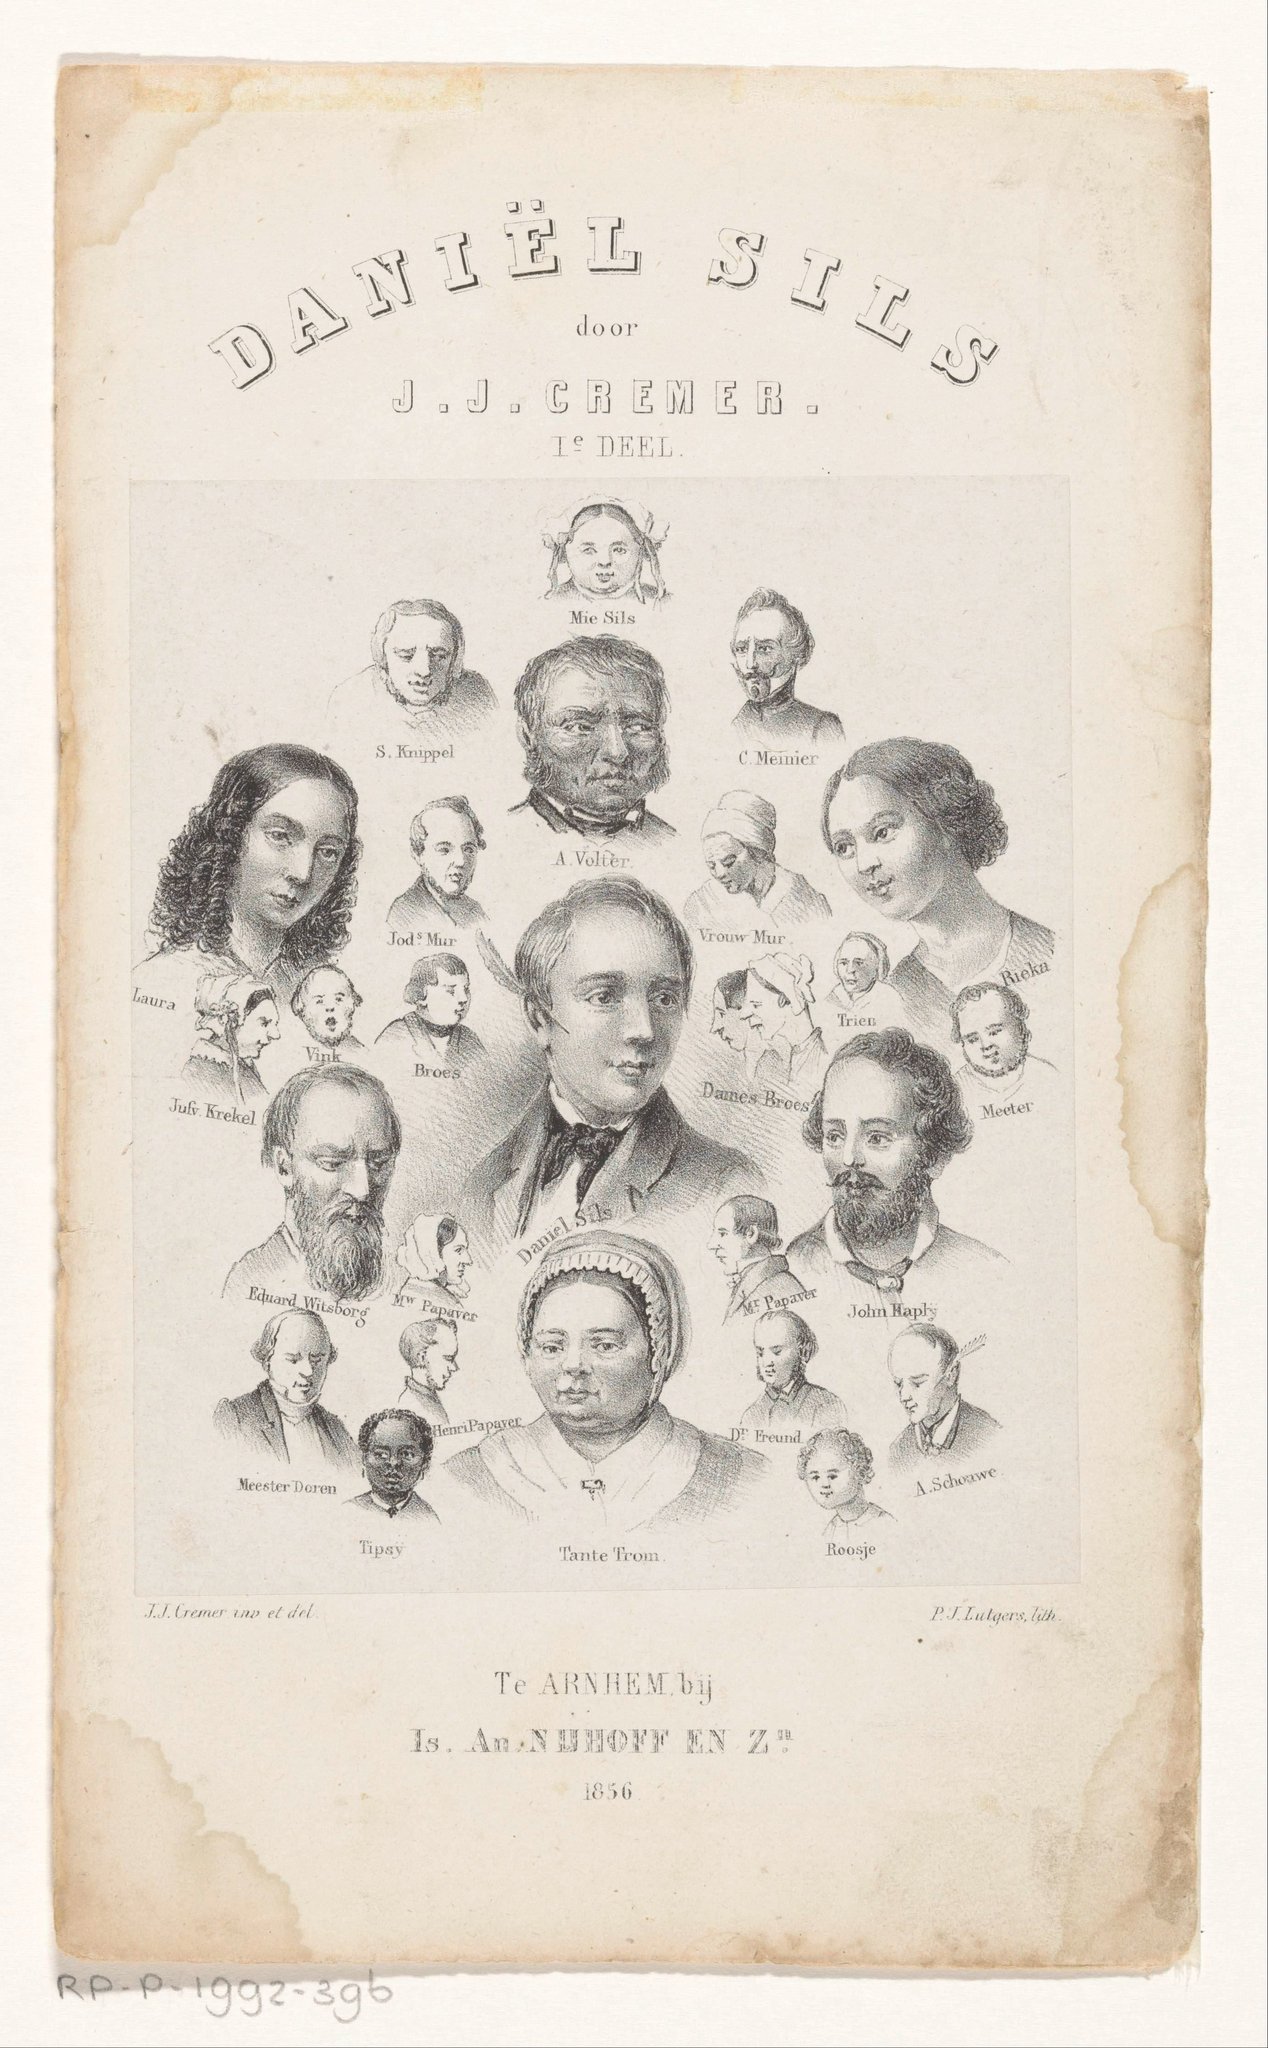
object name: titelblad, titelpagina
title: Portretten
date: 1856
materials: paper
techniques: lithograph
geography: arnhem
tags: the (nude) human figure; 'corpo humano' (ripa)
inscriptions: collector's mark: Lugt 2228, collector's mark: Lugt 2760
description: Titelpagina voor: Cremer, Jacob. Daniël Sils. Arnhem: Nijhoff en Zn, Isaac Anne, 1856.